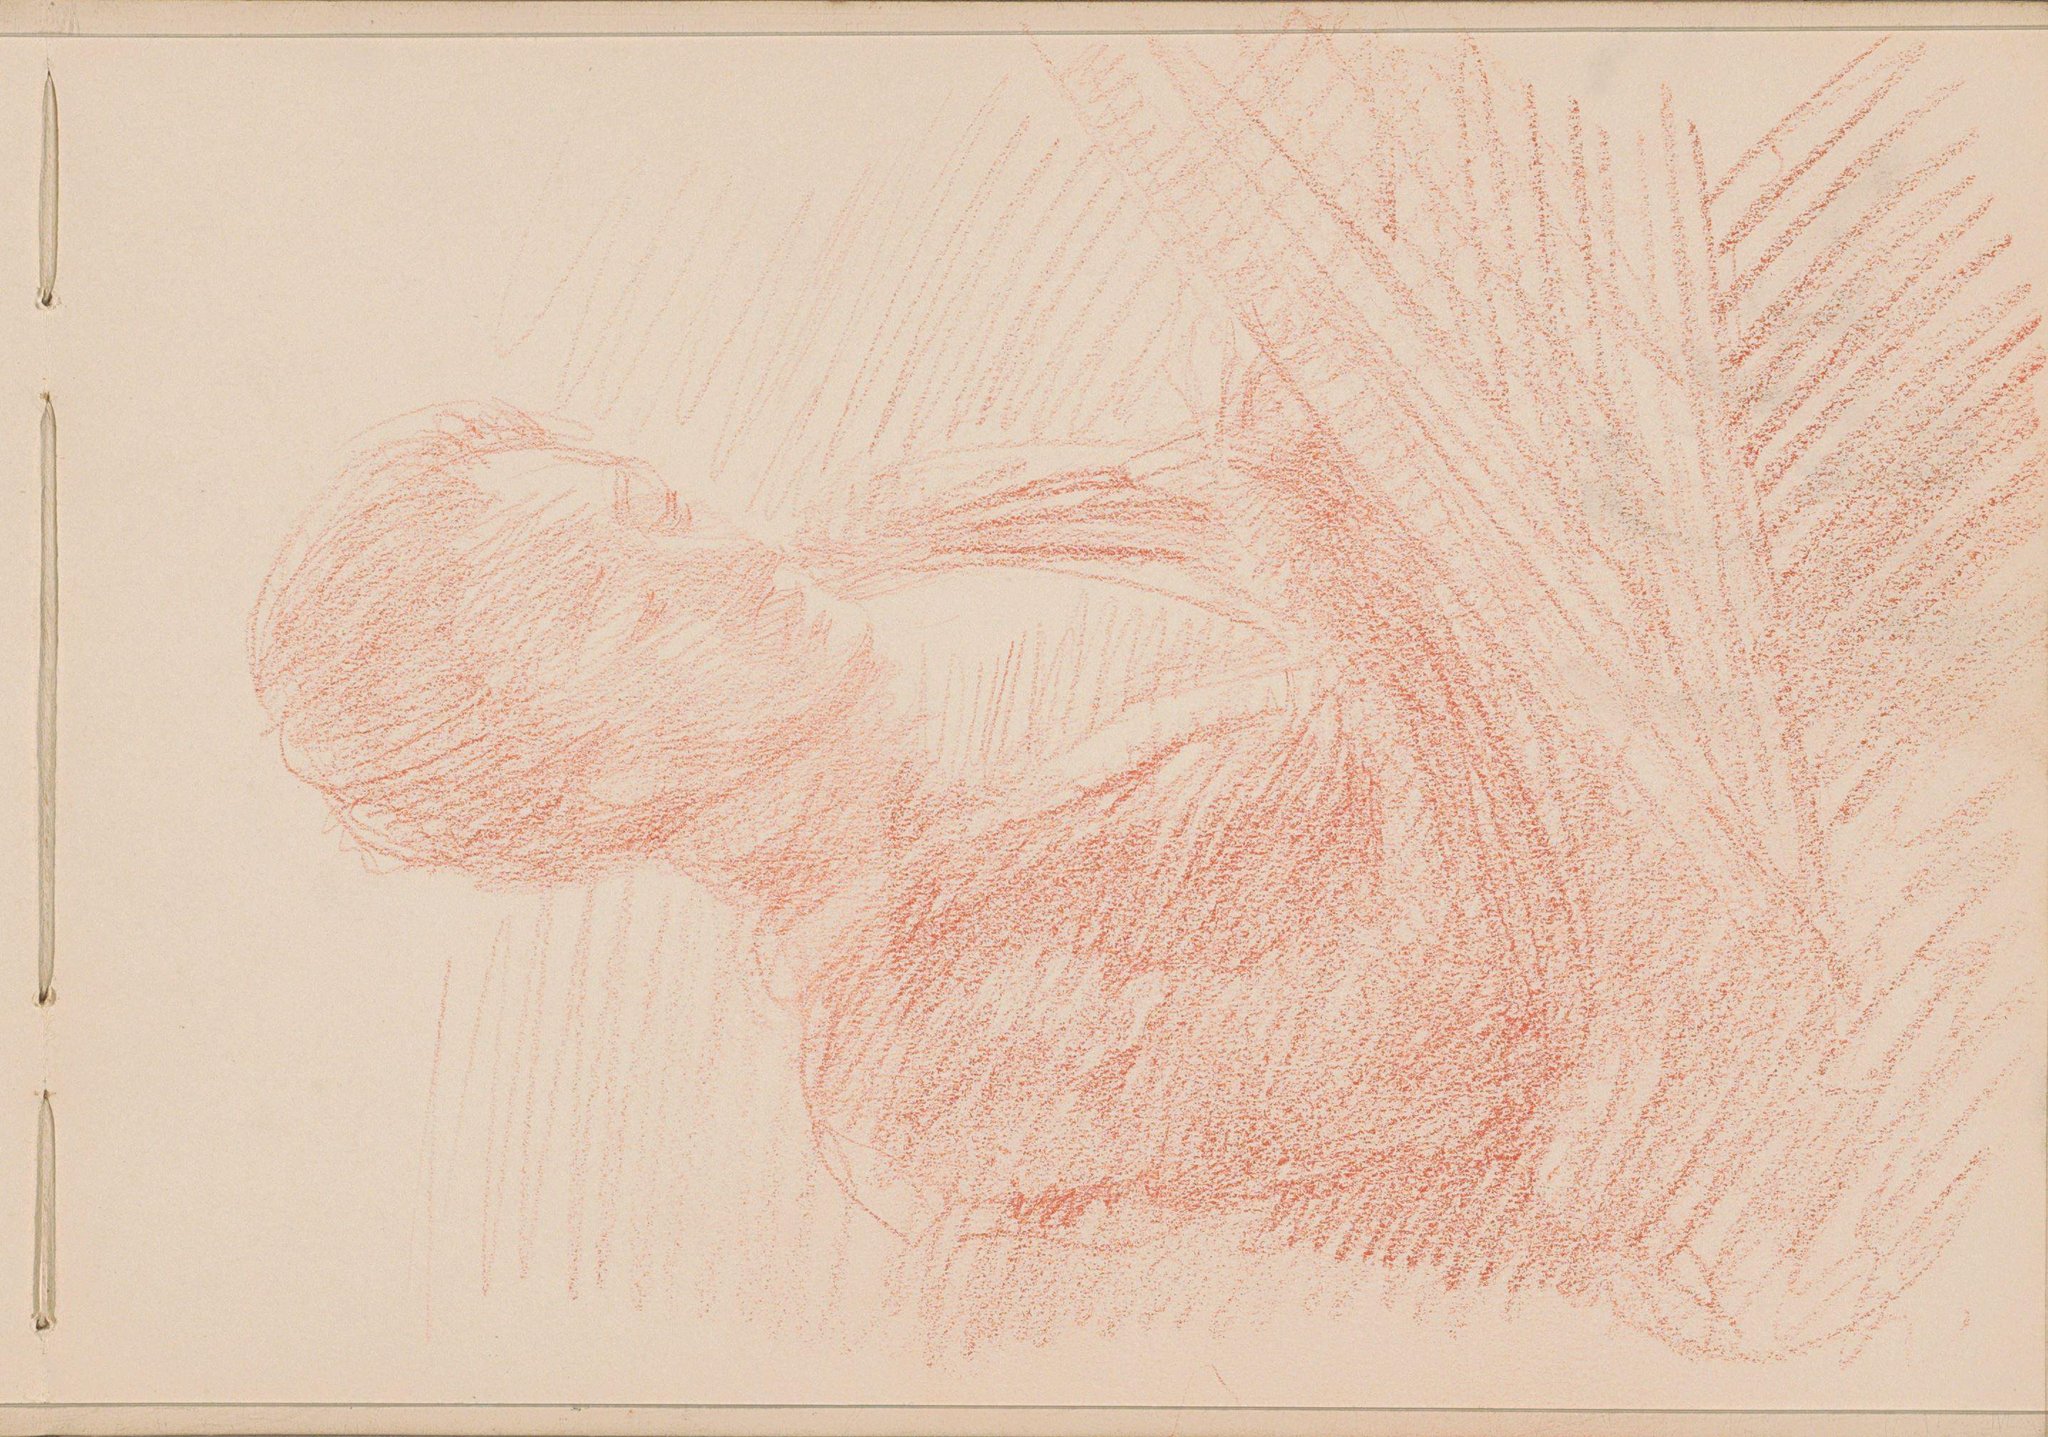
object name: sketchbook leaf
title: Vrouw, schetsend achter een tekenblok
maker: a.a.l. de grammont-hubrecht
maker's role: draughtsman, painter, print maker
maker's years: 1855-1913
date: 1865-1913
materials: chalk, paper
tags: sitting figure, adult woman, artist (in general) making preliminary designs, sketching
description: Mogelijk een zelfportret of portret van een collega-kunstenares. Blad 42 recto uit een schetsboek met 68 bladen.